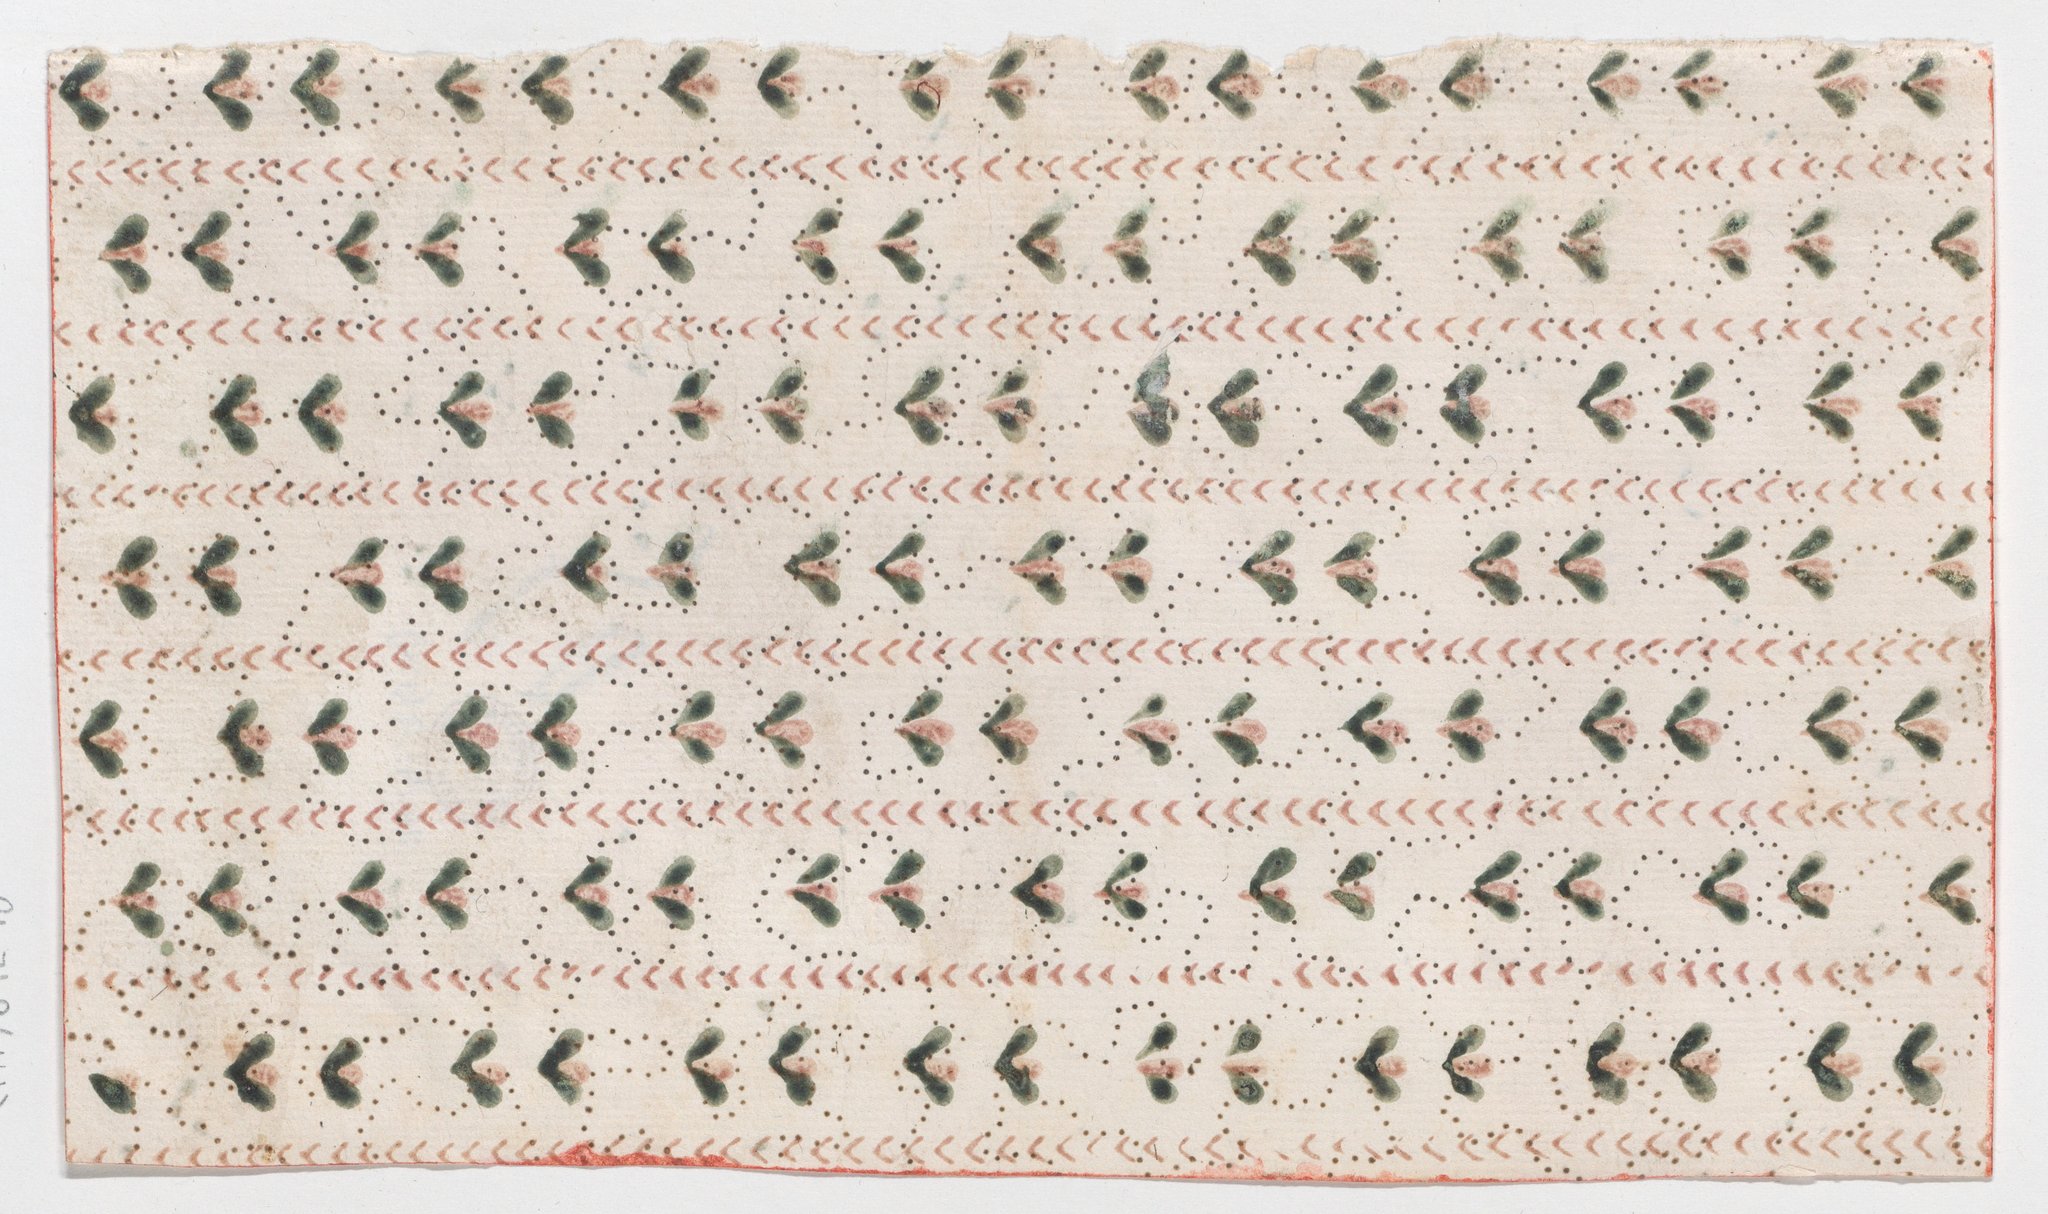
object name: print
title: Sheet with overall dot and floral pattern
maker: Anonymous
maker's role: artist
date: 1801-1900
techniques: relief print